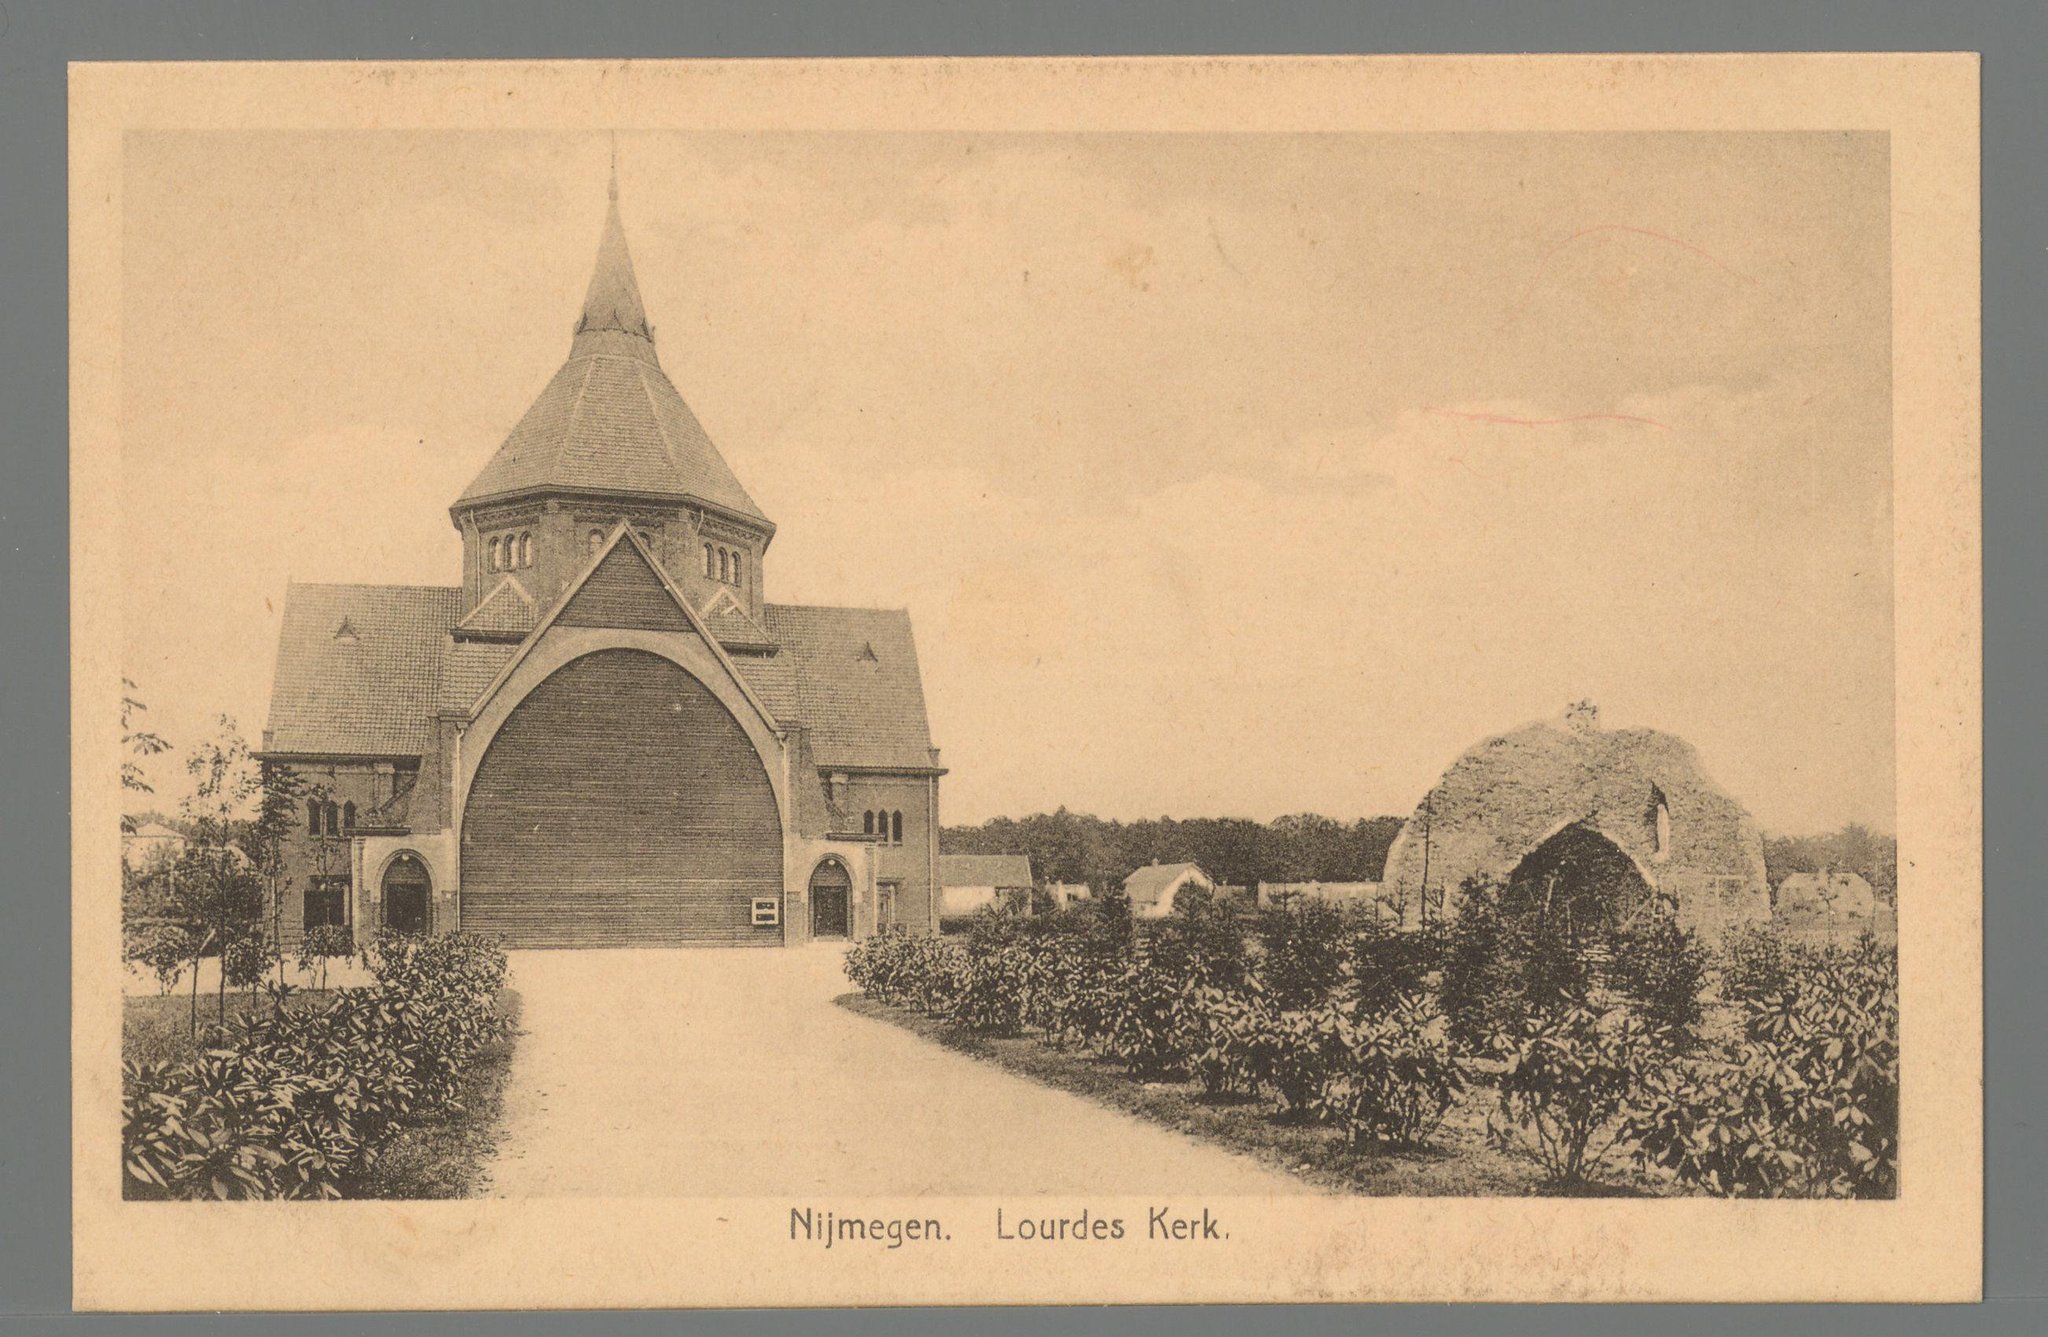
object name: photomechanical print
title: Nijmegen. Lourdes Kerk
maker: Anonymous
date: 1927-1935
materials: cardboard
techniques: photograph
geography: nijmegen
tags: church (exterior)